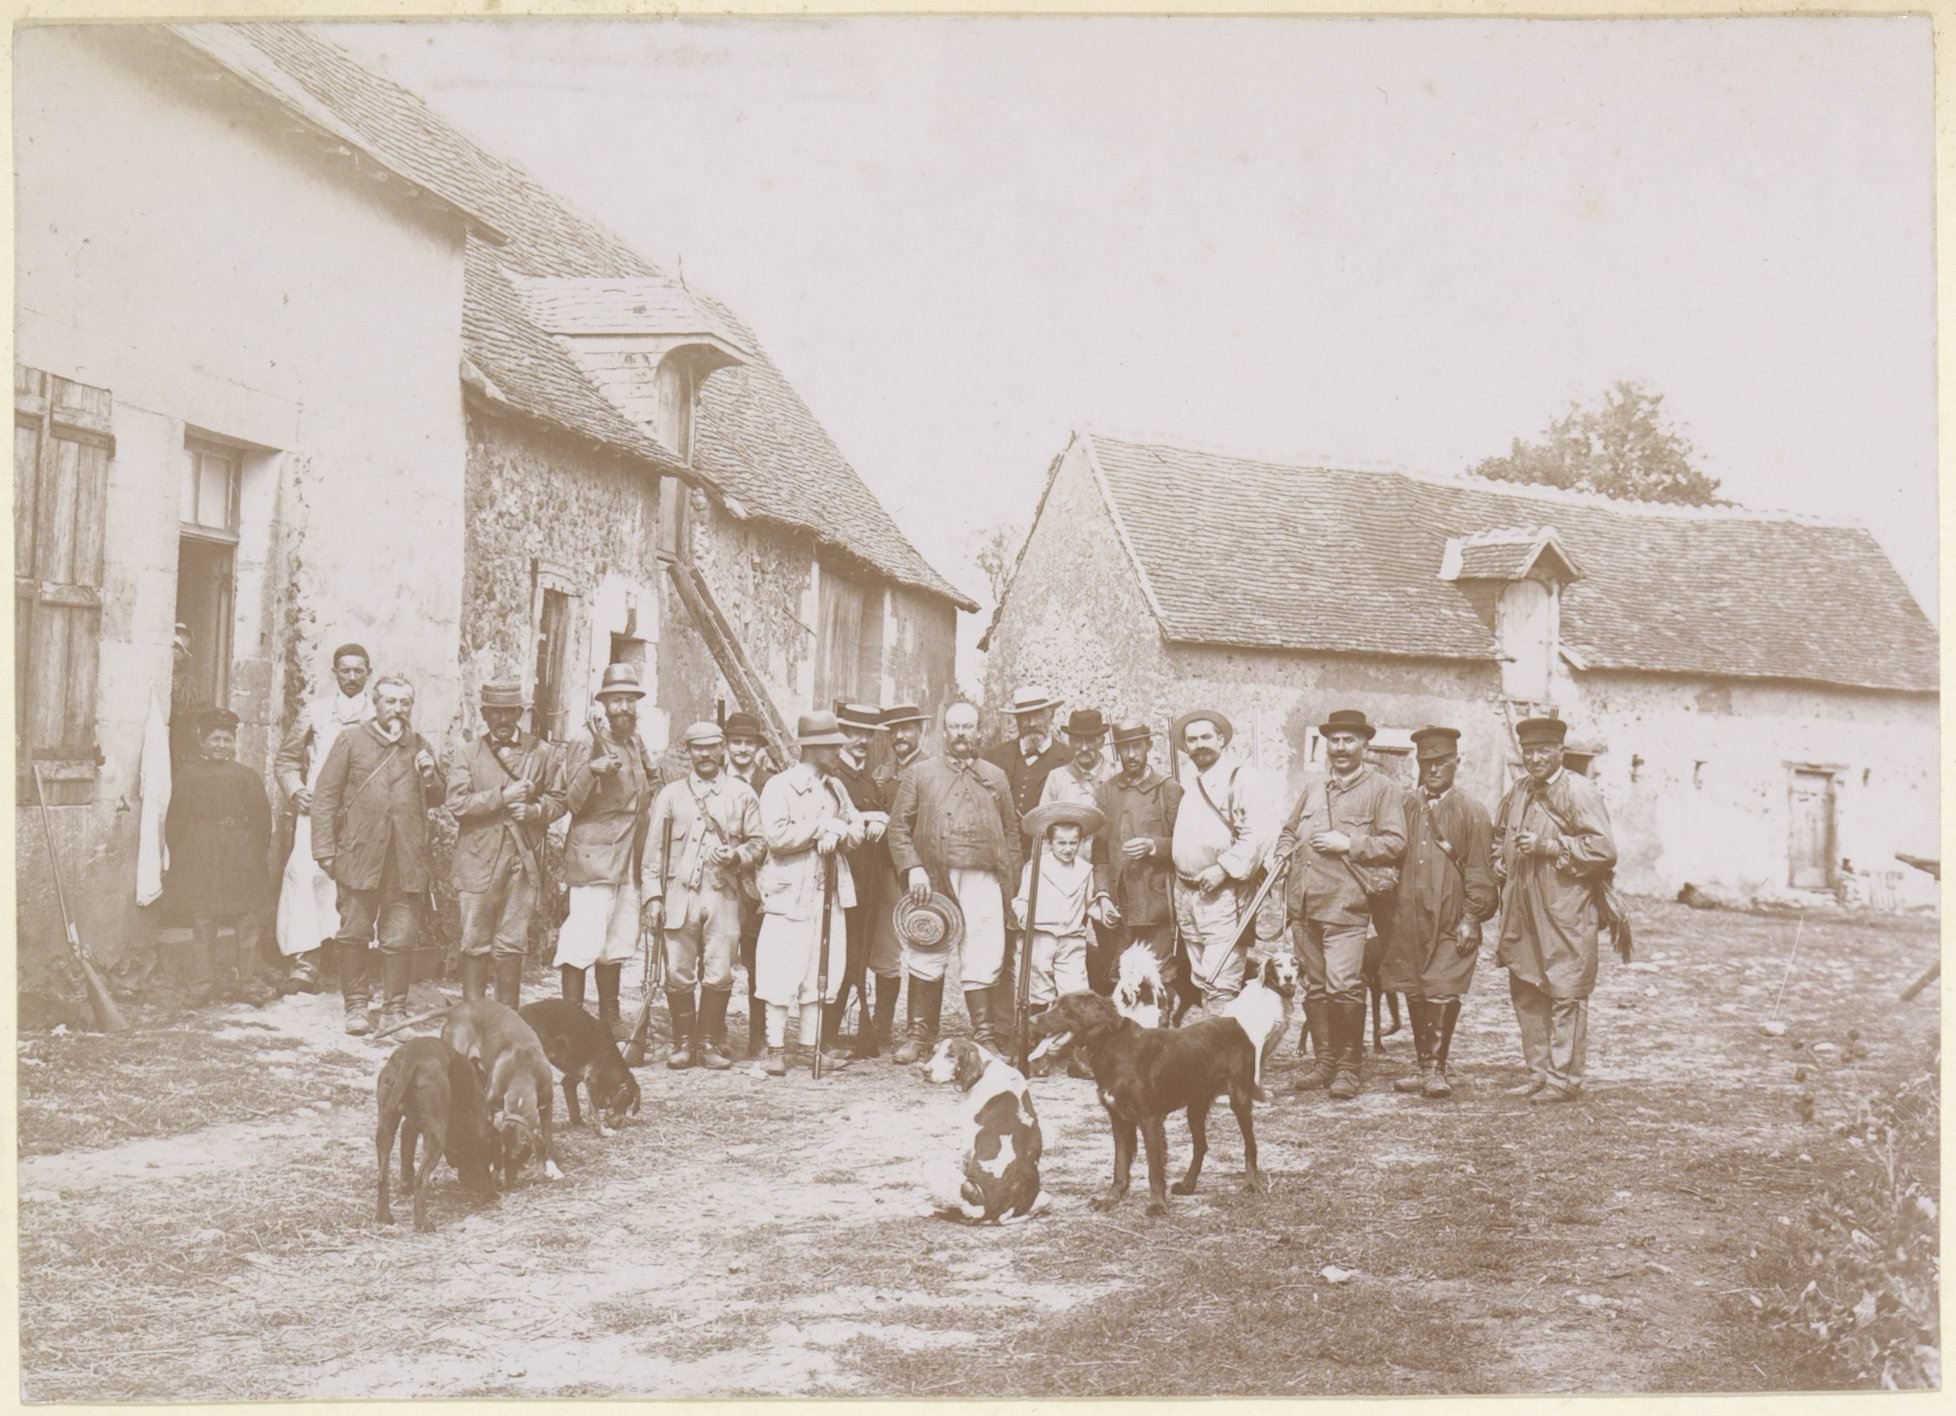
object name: photograph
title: Groepsportret van een jachtgezelschap op een erf in Frankrijk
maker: Anonymous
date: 1900-1910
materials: paper, photographic support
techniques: daylight paper print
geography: france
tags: group-portrait of hunters, hunting dogs, farm (building), france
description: Onderdeel van Fotoalbum van een Franse amateurfotograaf met opnames van een familie, distilleerderij Delizy & Doistau Fils, het leger en bezienswaardigheden in Frankrijk.